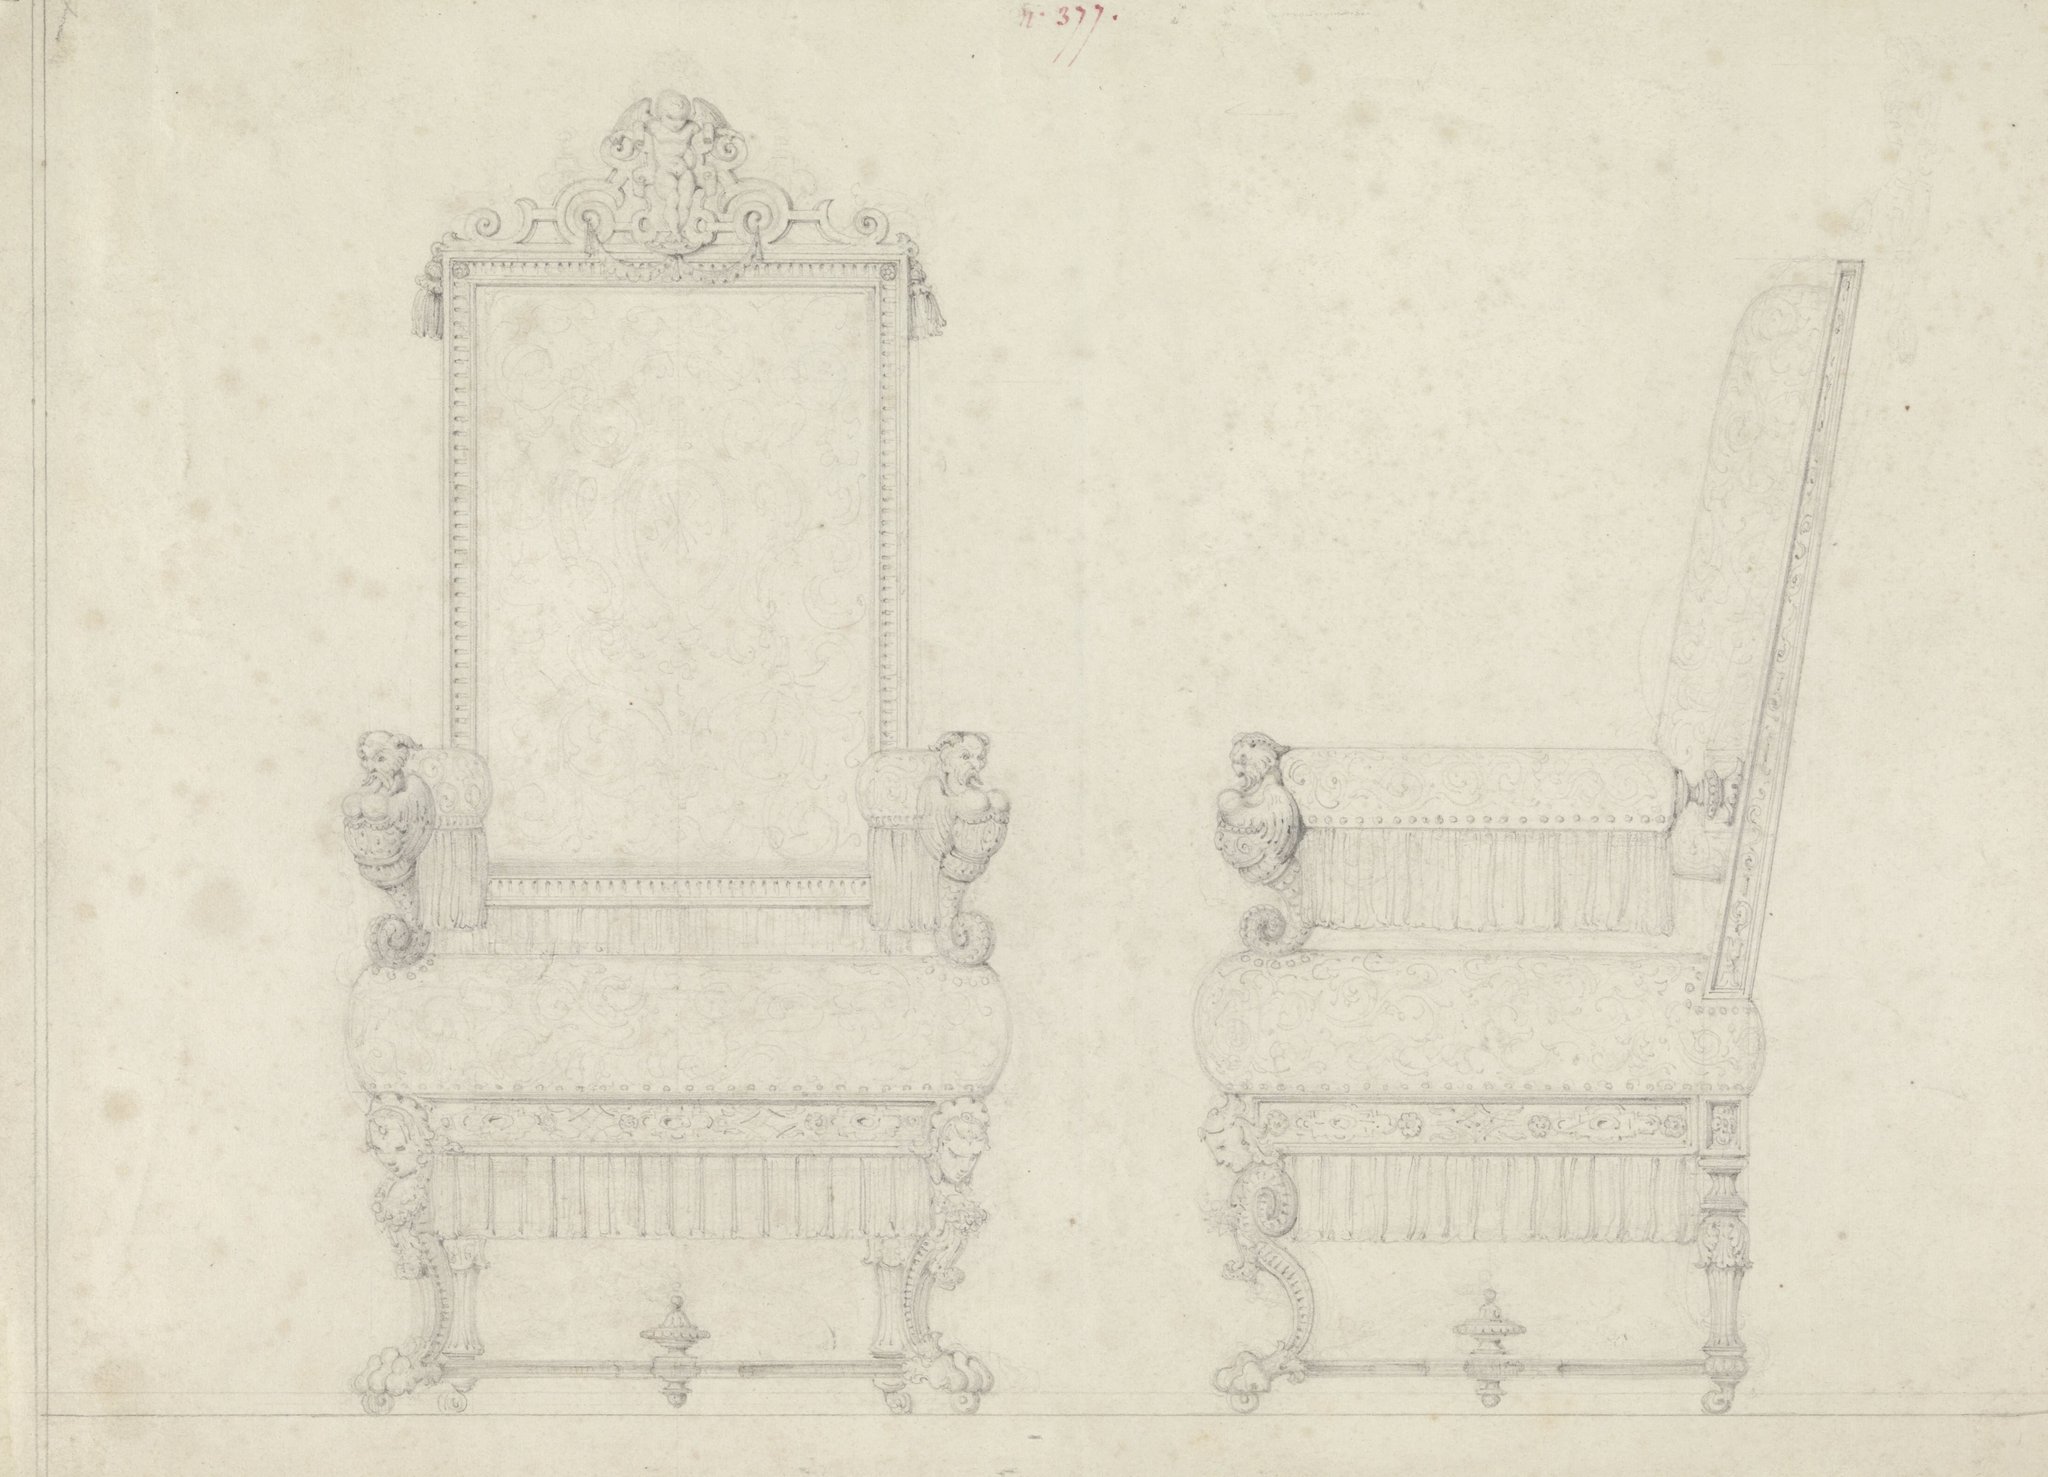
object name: design drawing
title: Ontwerp voor een armstoel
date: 1840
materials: graphite, ink, paper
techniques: pen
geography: france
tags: armchair, seat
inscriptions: inscription: ‘N° 377.’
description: Ontwerp voor een armstoel, gezien van voren en van rechts.